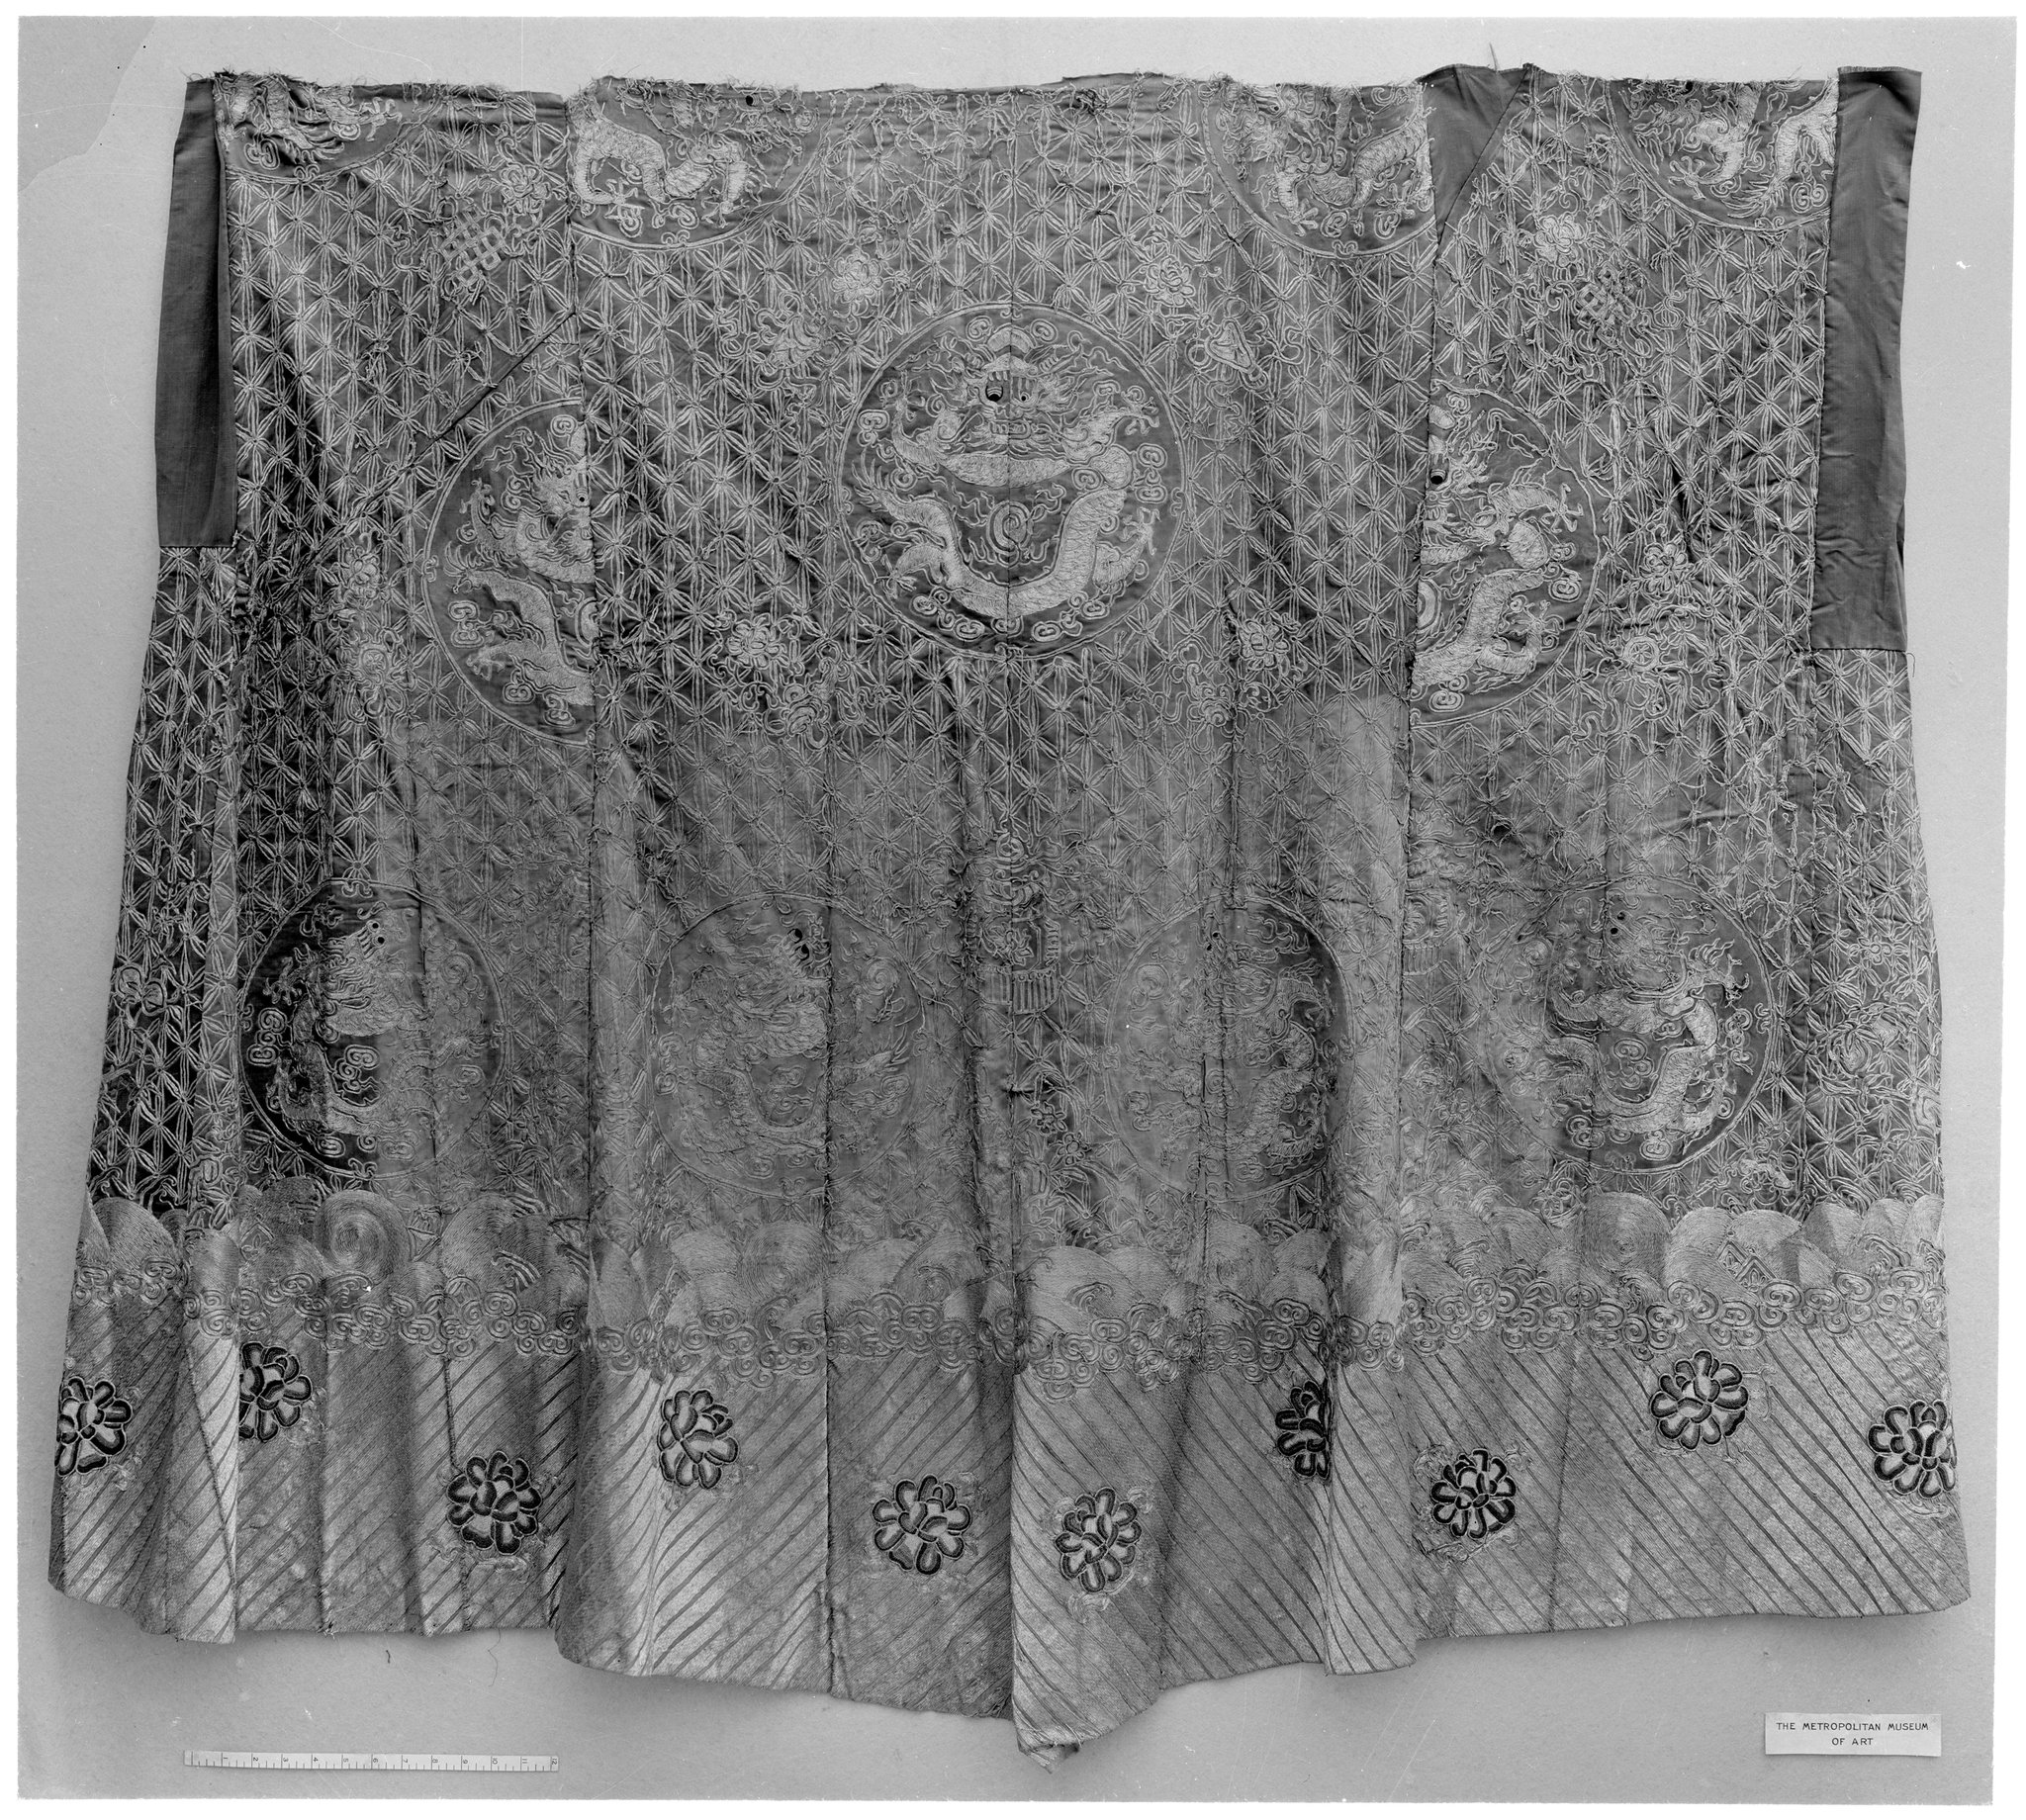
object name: robe, part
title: Part of Robe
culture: chinese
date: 1801-1900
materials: metal thread, silk